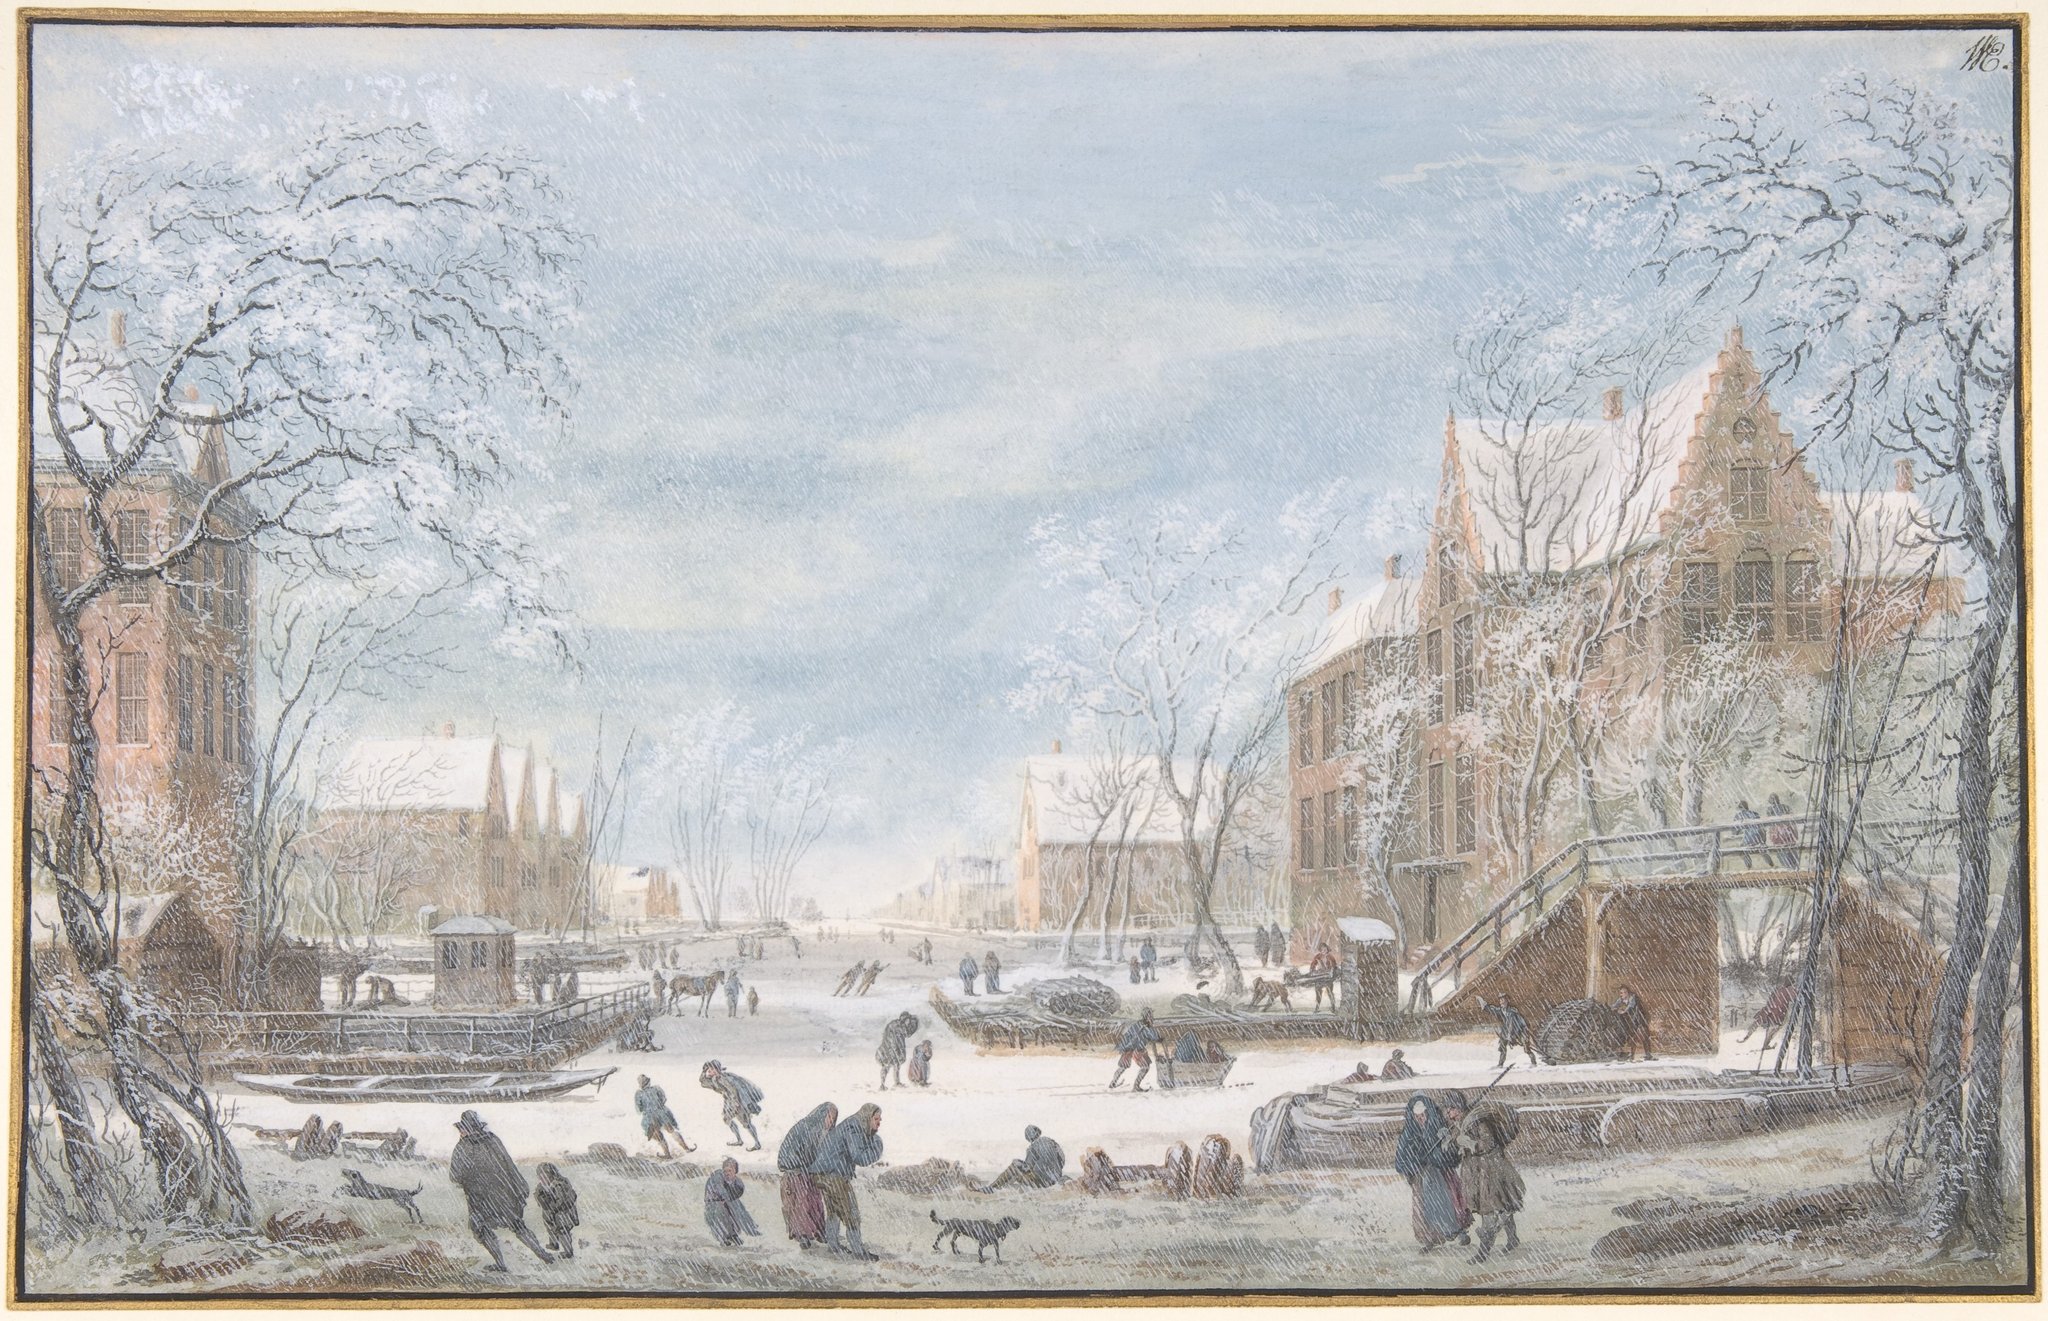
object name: drawing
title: Snow Falling on a Dutch Town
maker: abraham rademaker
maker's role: draughtsman, print maker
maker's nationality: dutch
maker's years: 1675-1735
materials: gilt, gouache, ink, watercolor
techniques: pen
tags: buildings,towns,snow,boats